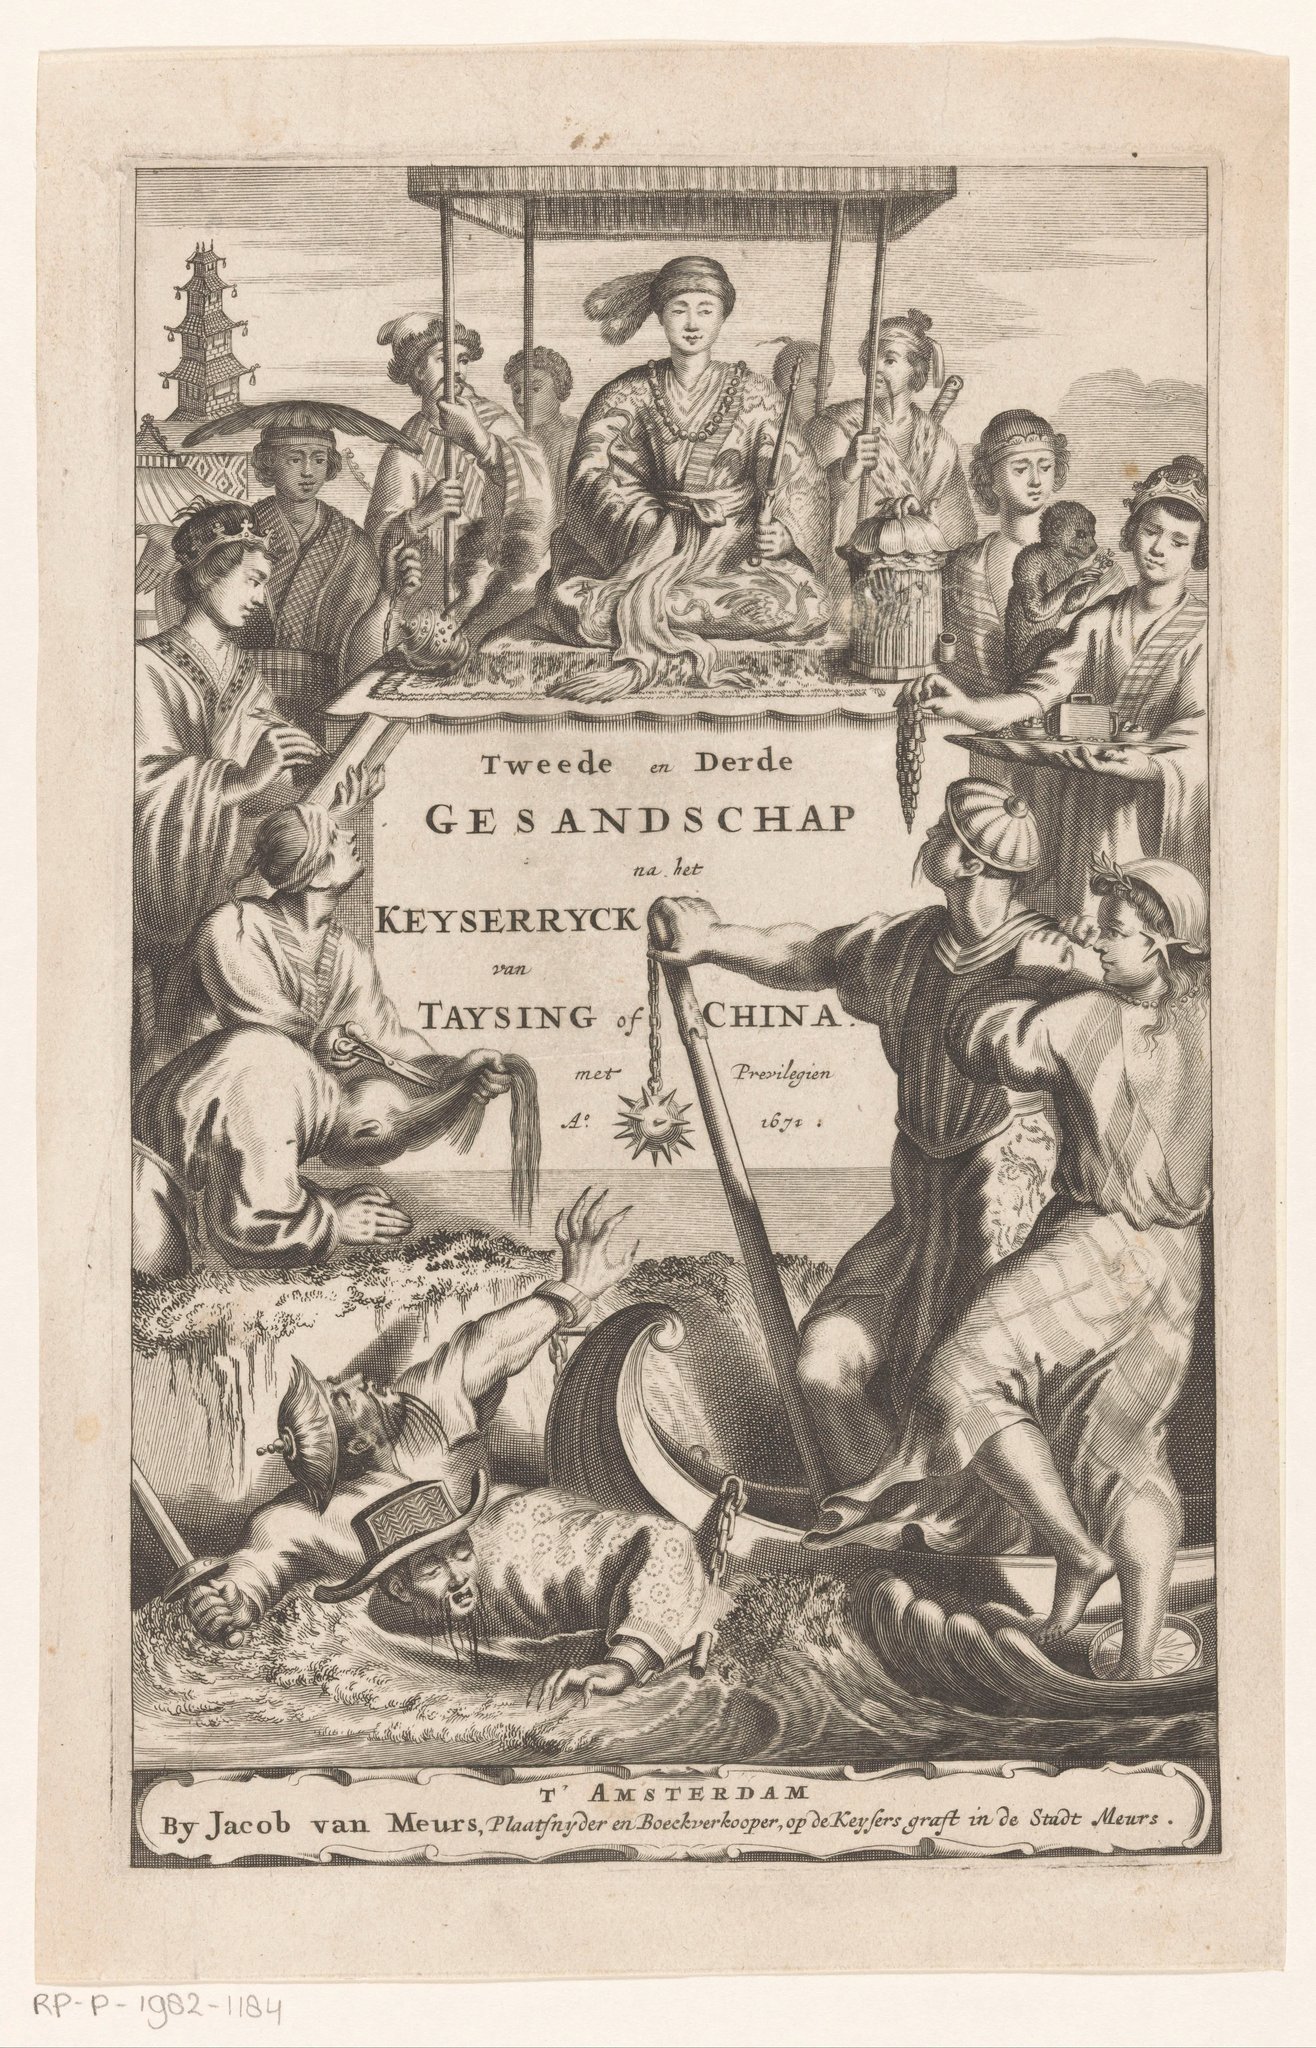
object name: print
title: Titelpagina voor: Olfert Dapper, Tweede en Derde Gesandschap na het Keyserryck van Taysing of China, 1671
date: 1671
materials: paper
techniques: engraving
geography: amsterdam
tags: chinese, throne, emperor, house personnel, servants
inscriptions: collector's mark: Lugt 2760, collector's mark: Lugt 2228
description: Een Chinese keizer zit in kleermakerszit onder een baldakijn op een troon. Rondom staan bedienden met een wierookvat, een boek, een aap en een dienblad met eten. Links wordt bij een knielende figuur het haar afgeknipt. Op de voorgrond staan twee figuren met een knots in een boot, in het water liggen twee geketende figuren.